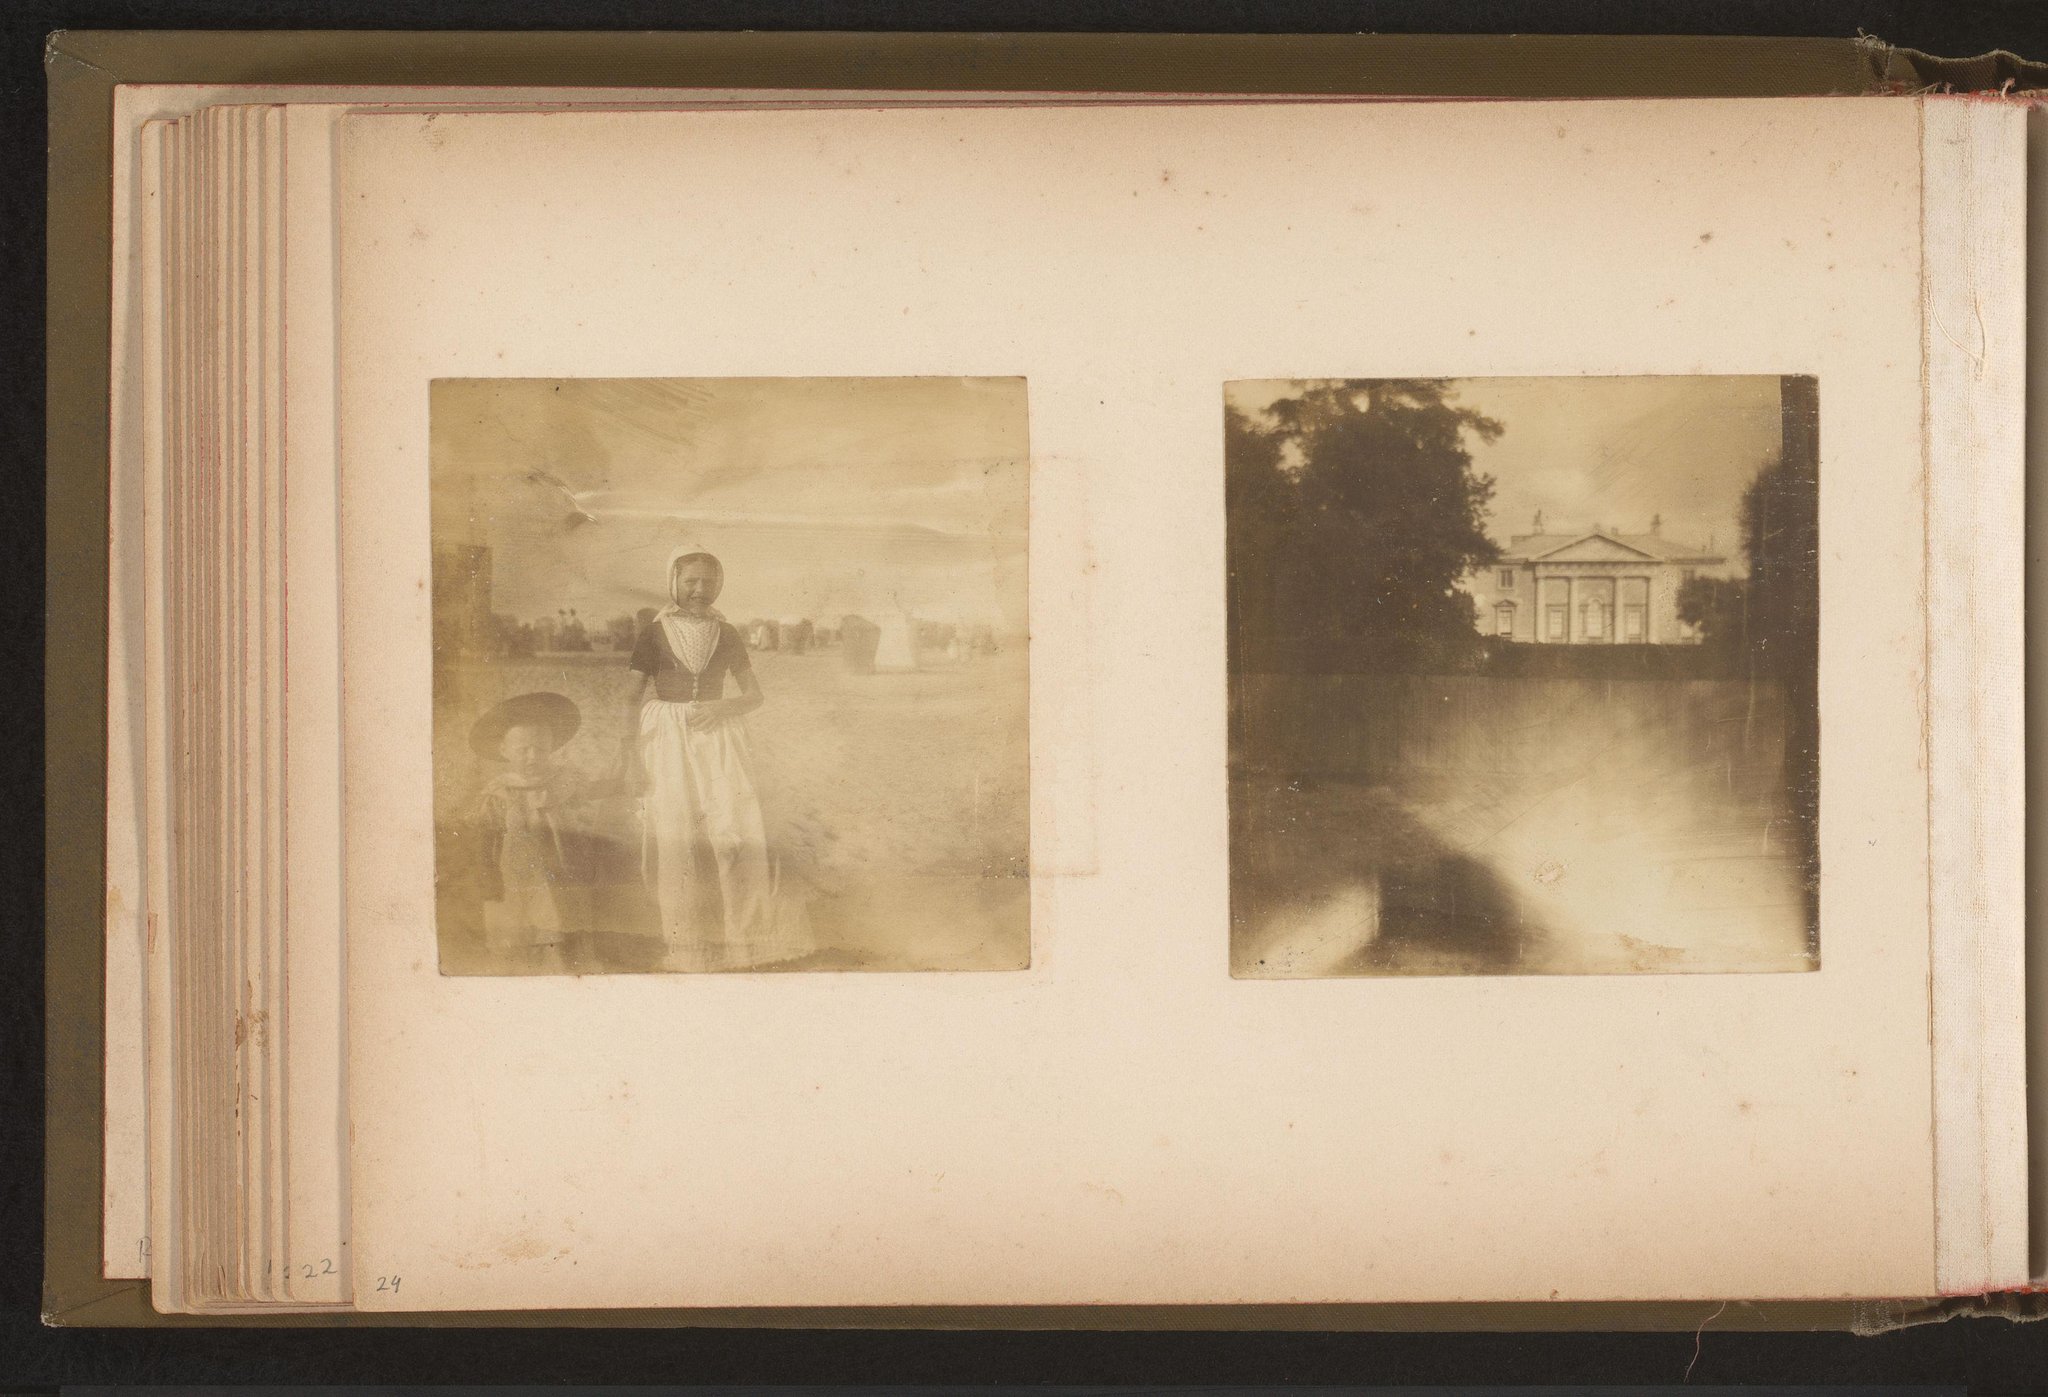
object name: album leaf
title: Twee foto's van kinderen op een strand en van een landhuis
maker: Anonymous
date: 1895-1910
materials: paper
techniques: albumen print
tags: beach (as place of recreation), child, country-house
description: Deze foto's maken deel uit van een album.